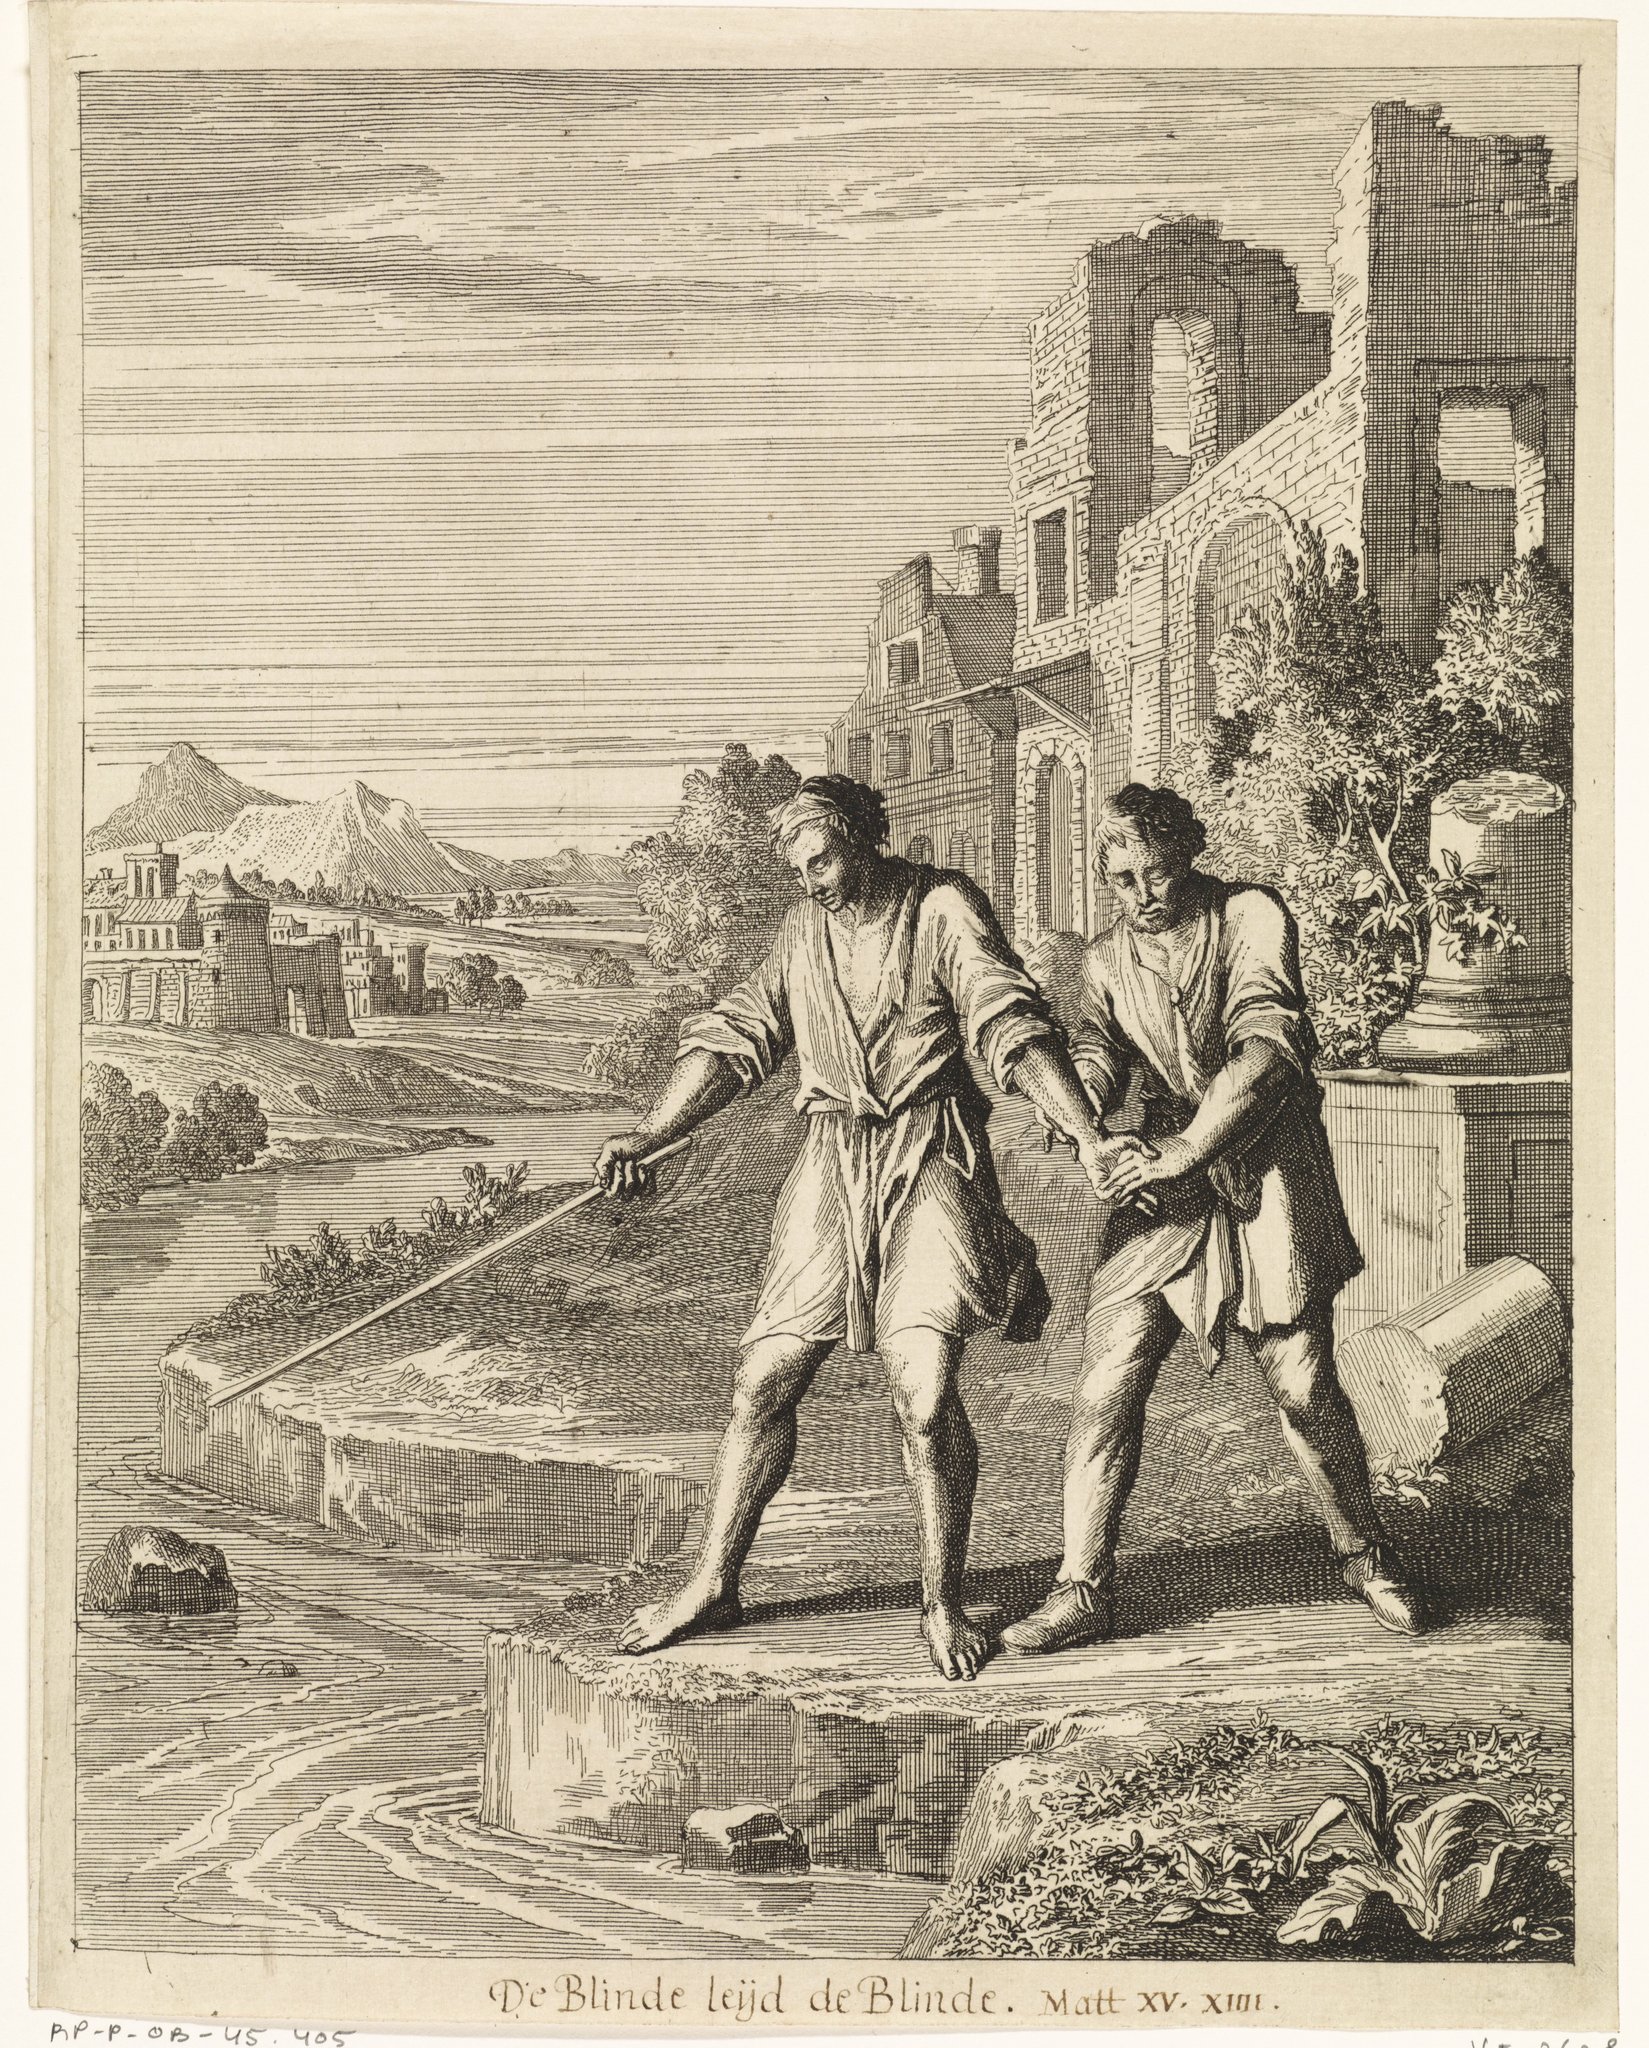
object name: print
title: Blinden leiden de blinden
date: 1708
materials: paper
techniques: etching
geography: nuremberg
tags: the blind leading the blind (matthew 15:14)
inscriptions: collector's mark: Lugt 2228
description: Proefdruk van een prent welke is opgenomen als illustratie in: Historiae Celebriores Veteris Testamenti. Christoph Weigel, 1708.